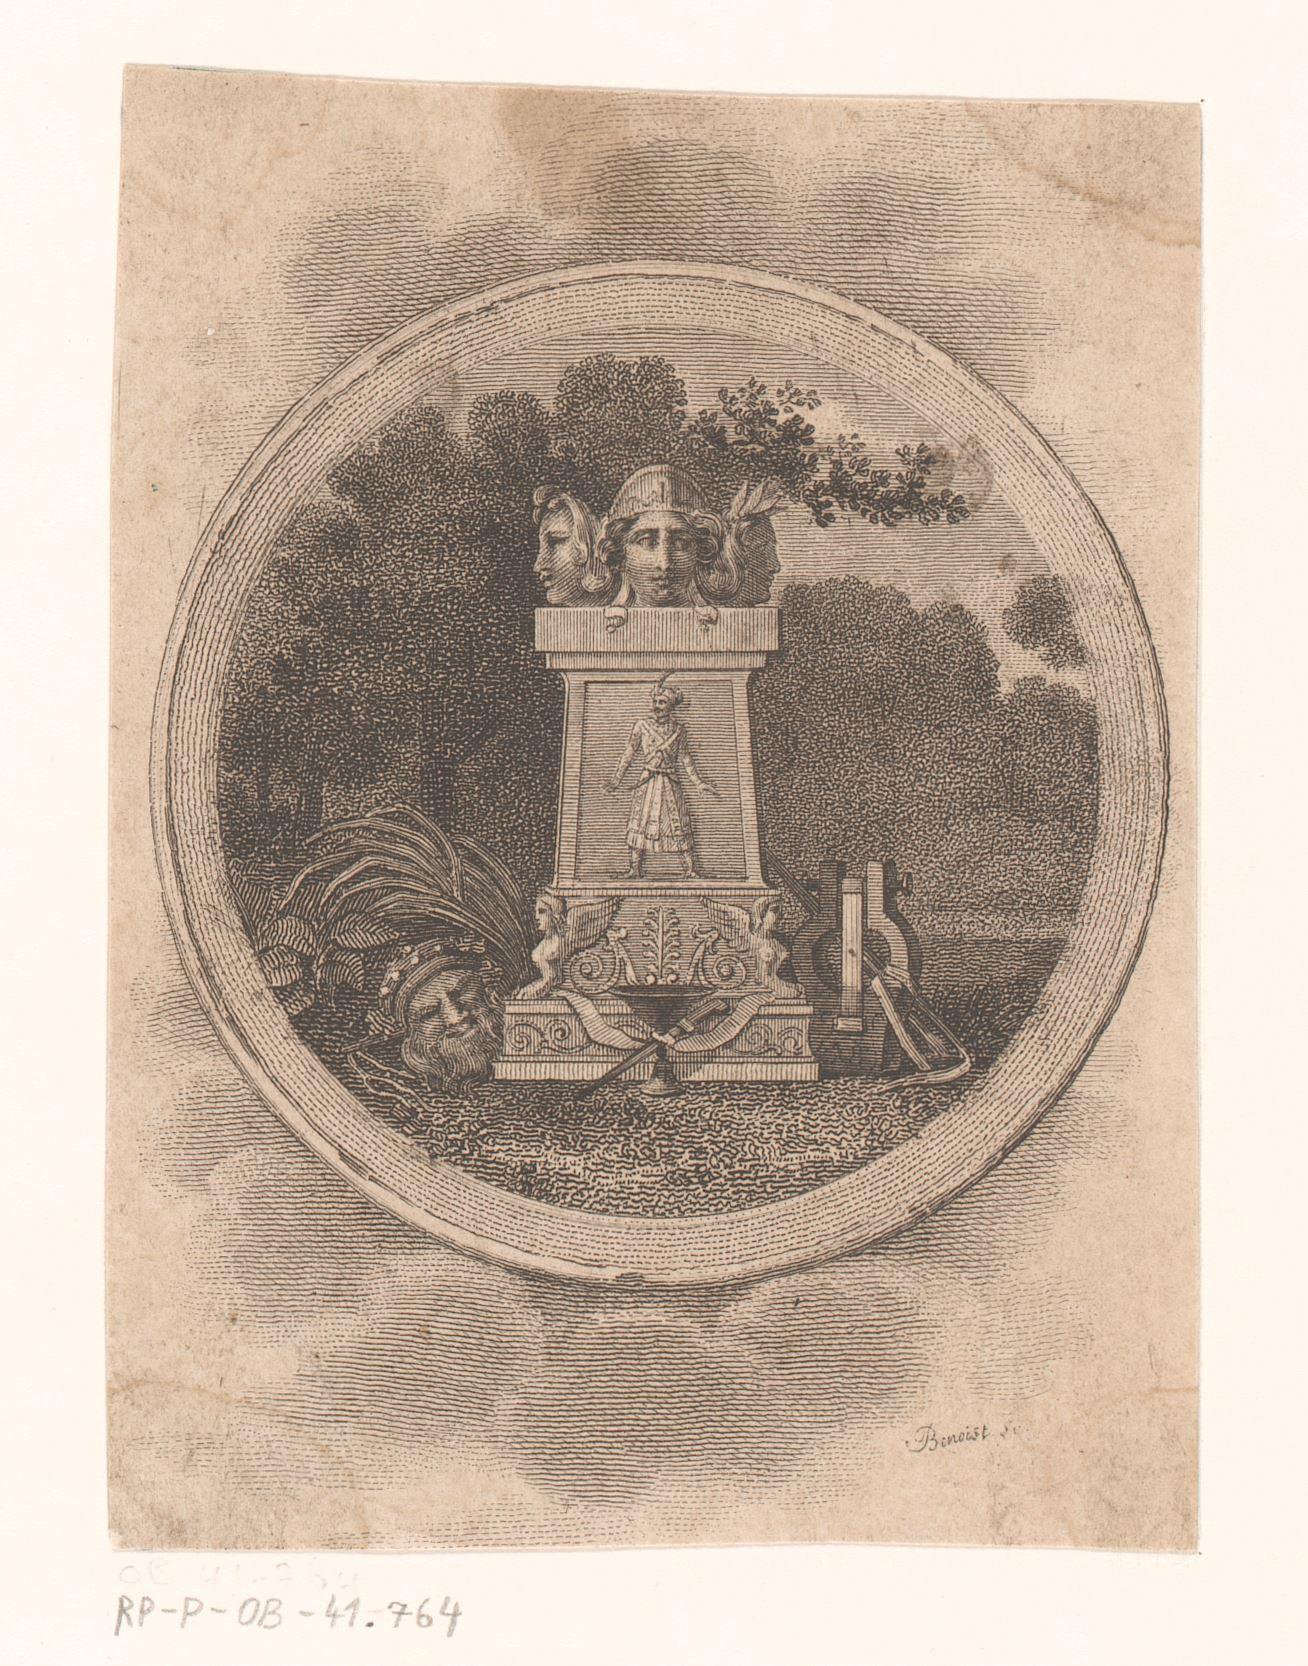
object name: print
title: Gedecoreerde zuil met verwijzingen naar de antieke oudheid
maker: guillaume philippe benoist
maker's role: print maker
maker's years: 1725-1800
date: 1735-1800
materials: paper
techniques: etching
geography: france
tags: lyre, cithara, psaltery, base (~ column, pillar)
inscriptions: collector's mark: Lugt 2228